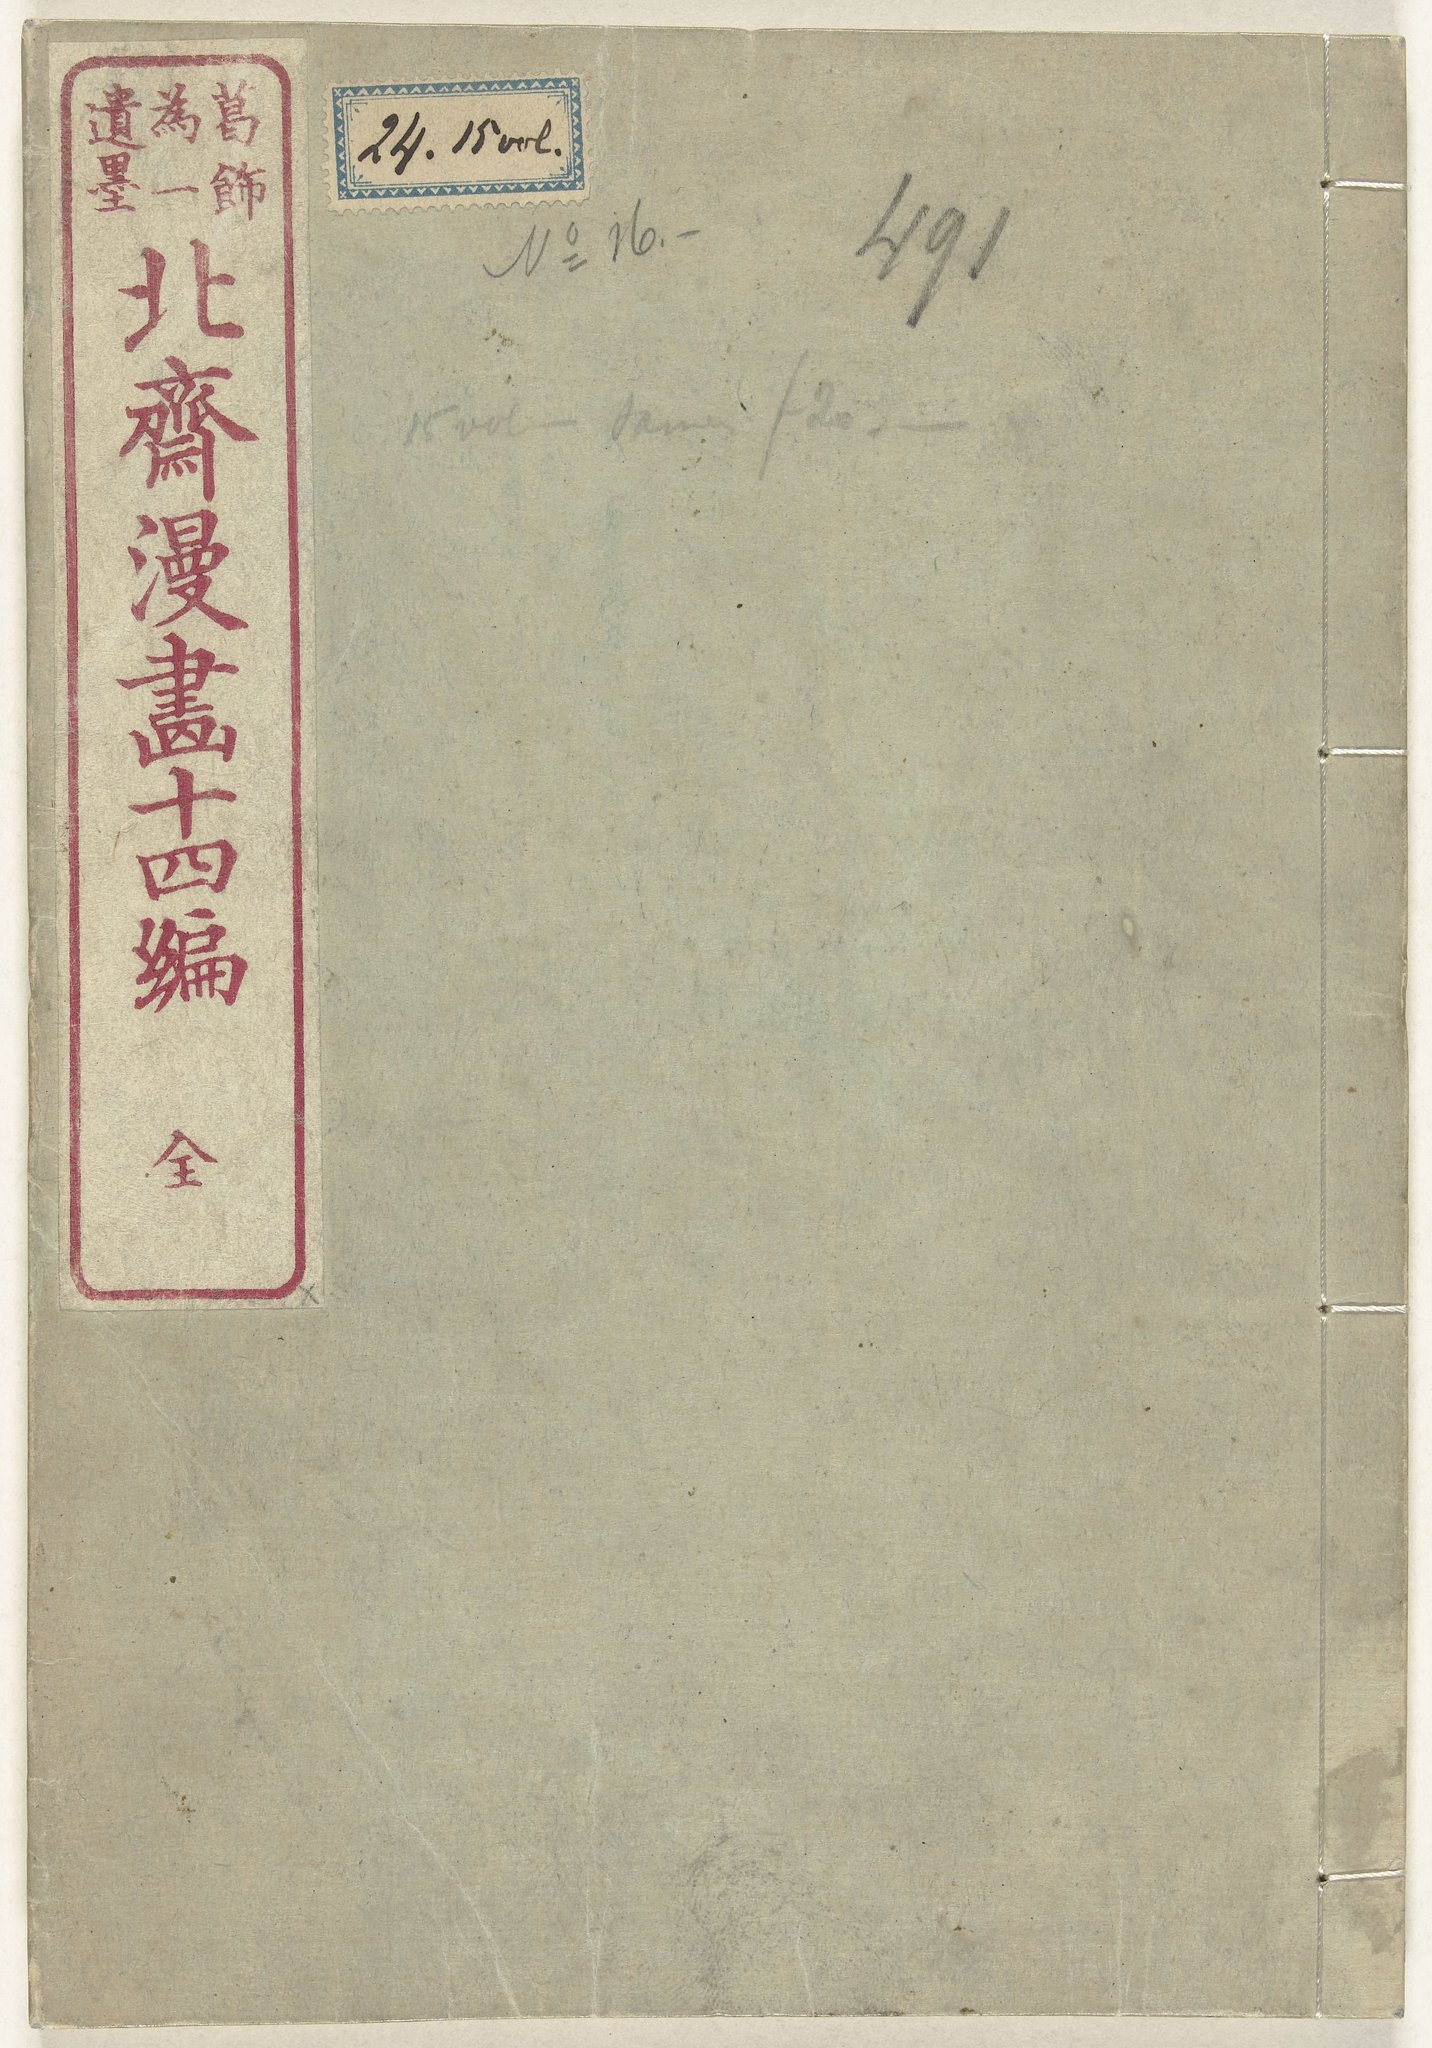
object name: book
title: Katsushika iitsu iboku Hokusai manga juyonpen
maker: katsushika hokusai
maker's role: draughtsman, print maker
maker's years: 1760-1849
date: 1878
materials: paper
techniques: woodcut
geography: tokyo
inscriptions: collector's mark: Lugt 2228, collector's mark: ‘Rijksschool voor kunstnijverheid’ Lugt 3937